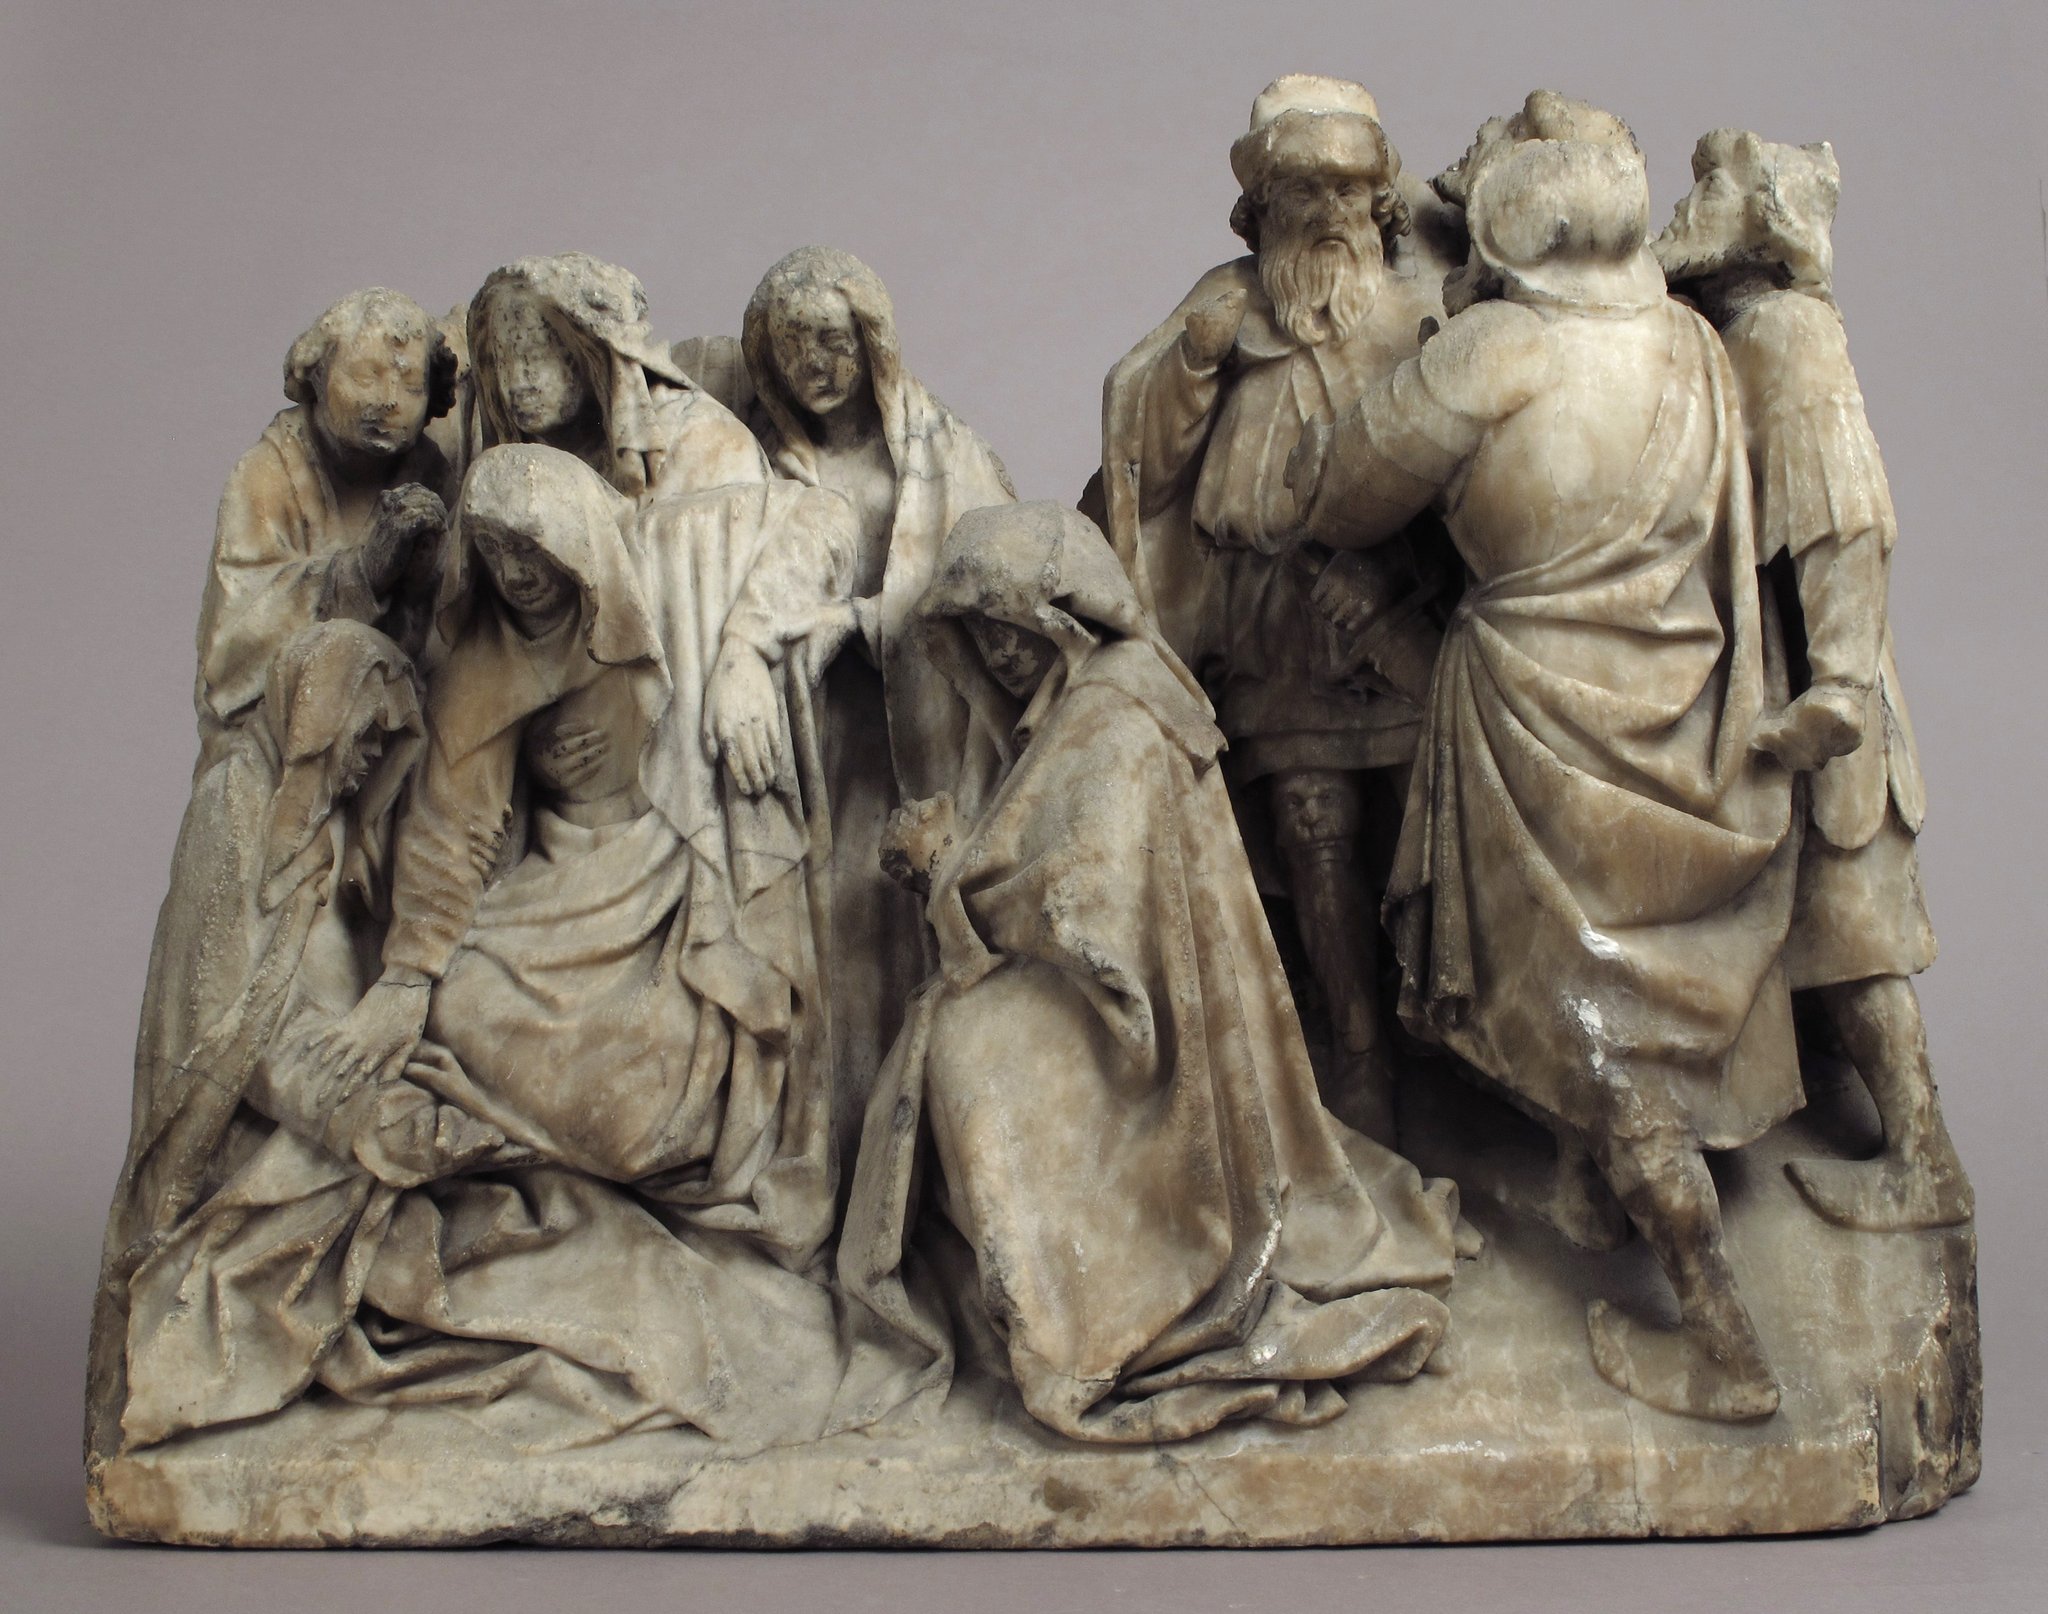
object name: relief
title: Mourners and Soldiers from a Crucifixion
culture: south netherlandish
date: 1467-1500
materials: alabaster, paint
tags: soldiers,sadness,men